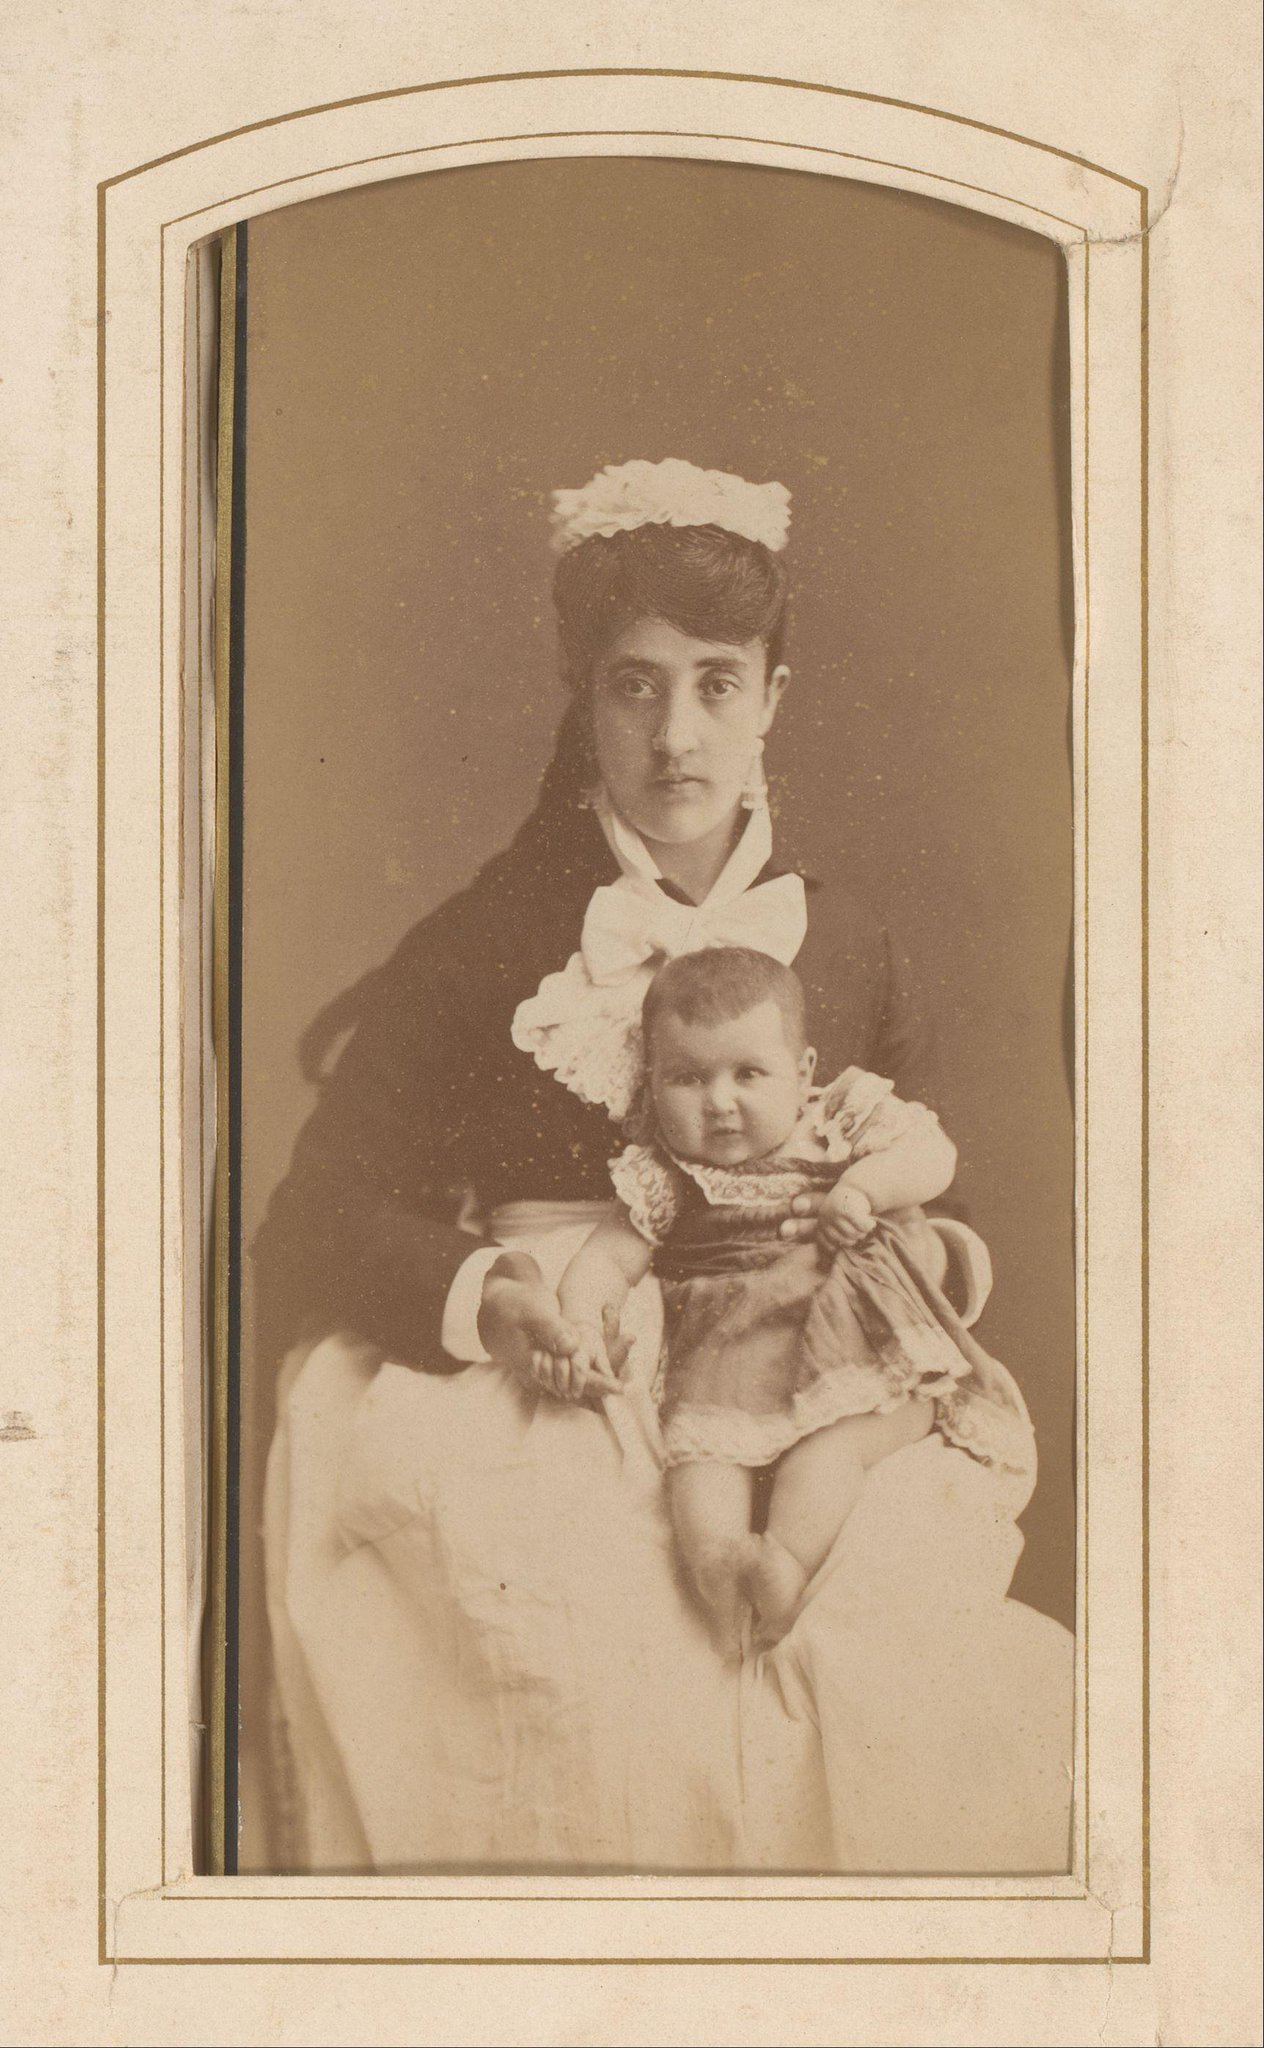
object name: photograph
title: Portret van een zittende vrouw met baby op schoot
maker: alviad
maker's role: fotograaf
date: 1870-1890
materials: cardboard, photographic support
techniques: albumen print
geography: madrid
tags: historical persons - bb - woman, mother and child(ren), woman and child(ren) (family group)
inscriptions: inscription: ‘Alviad/ Madrid/ Puerta del Sol. 14’